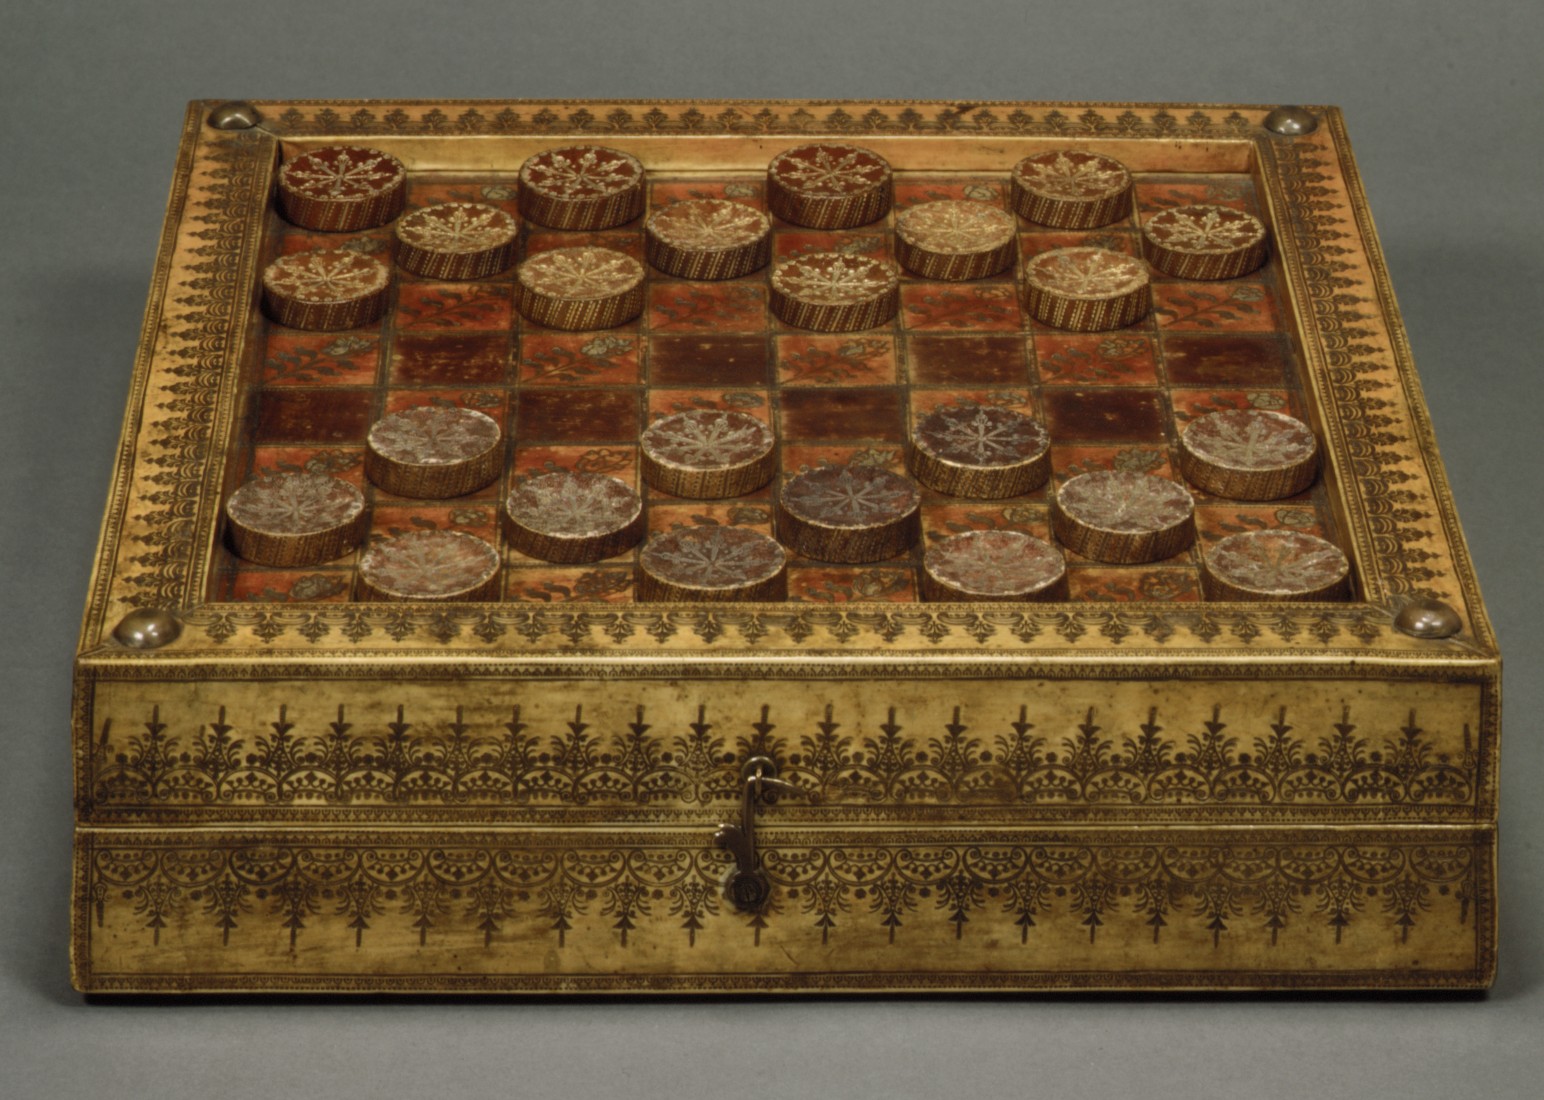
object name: draughtsman and box board for checker, backgammon and nine men's morris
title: Draughtsmen (30) and box-board for checkers, backgammon and nine-men's morris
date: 1834-1866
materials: gold, leather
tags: chess